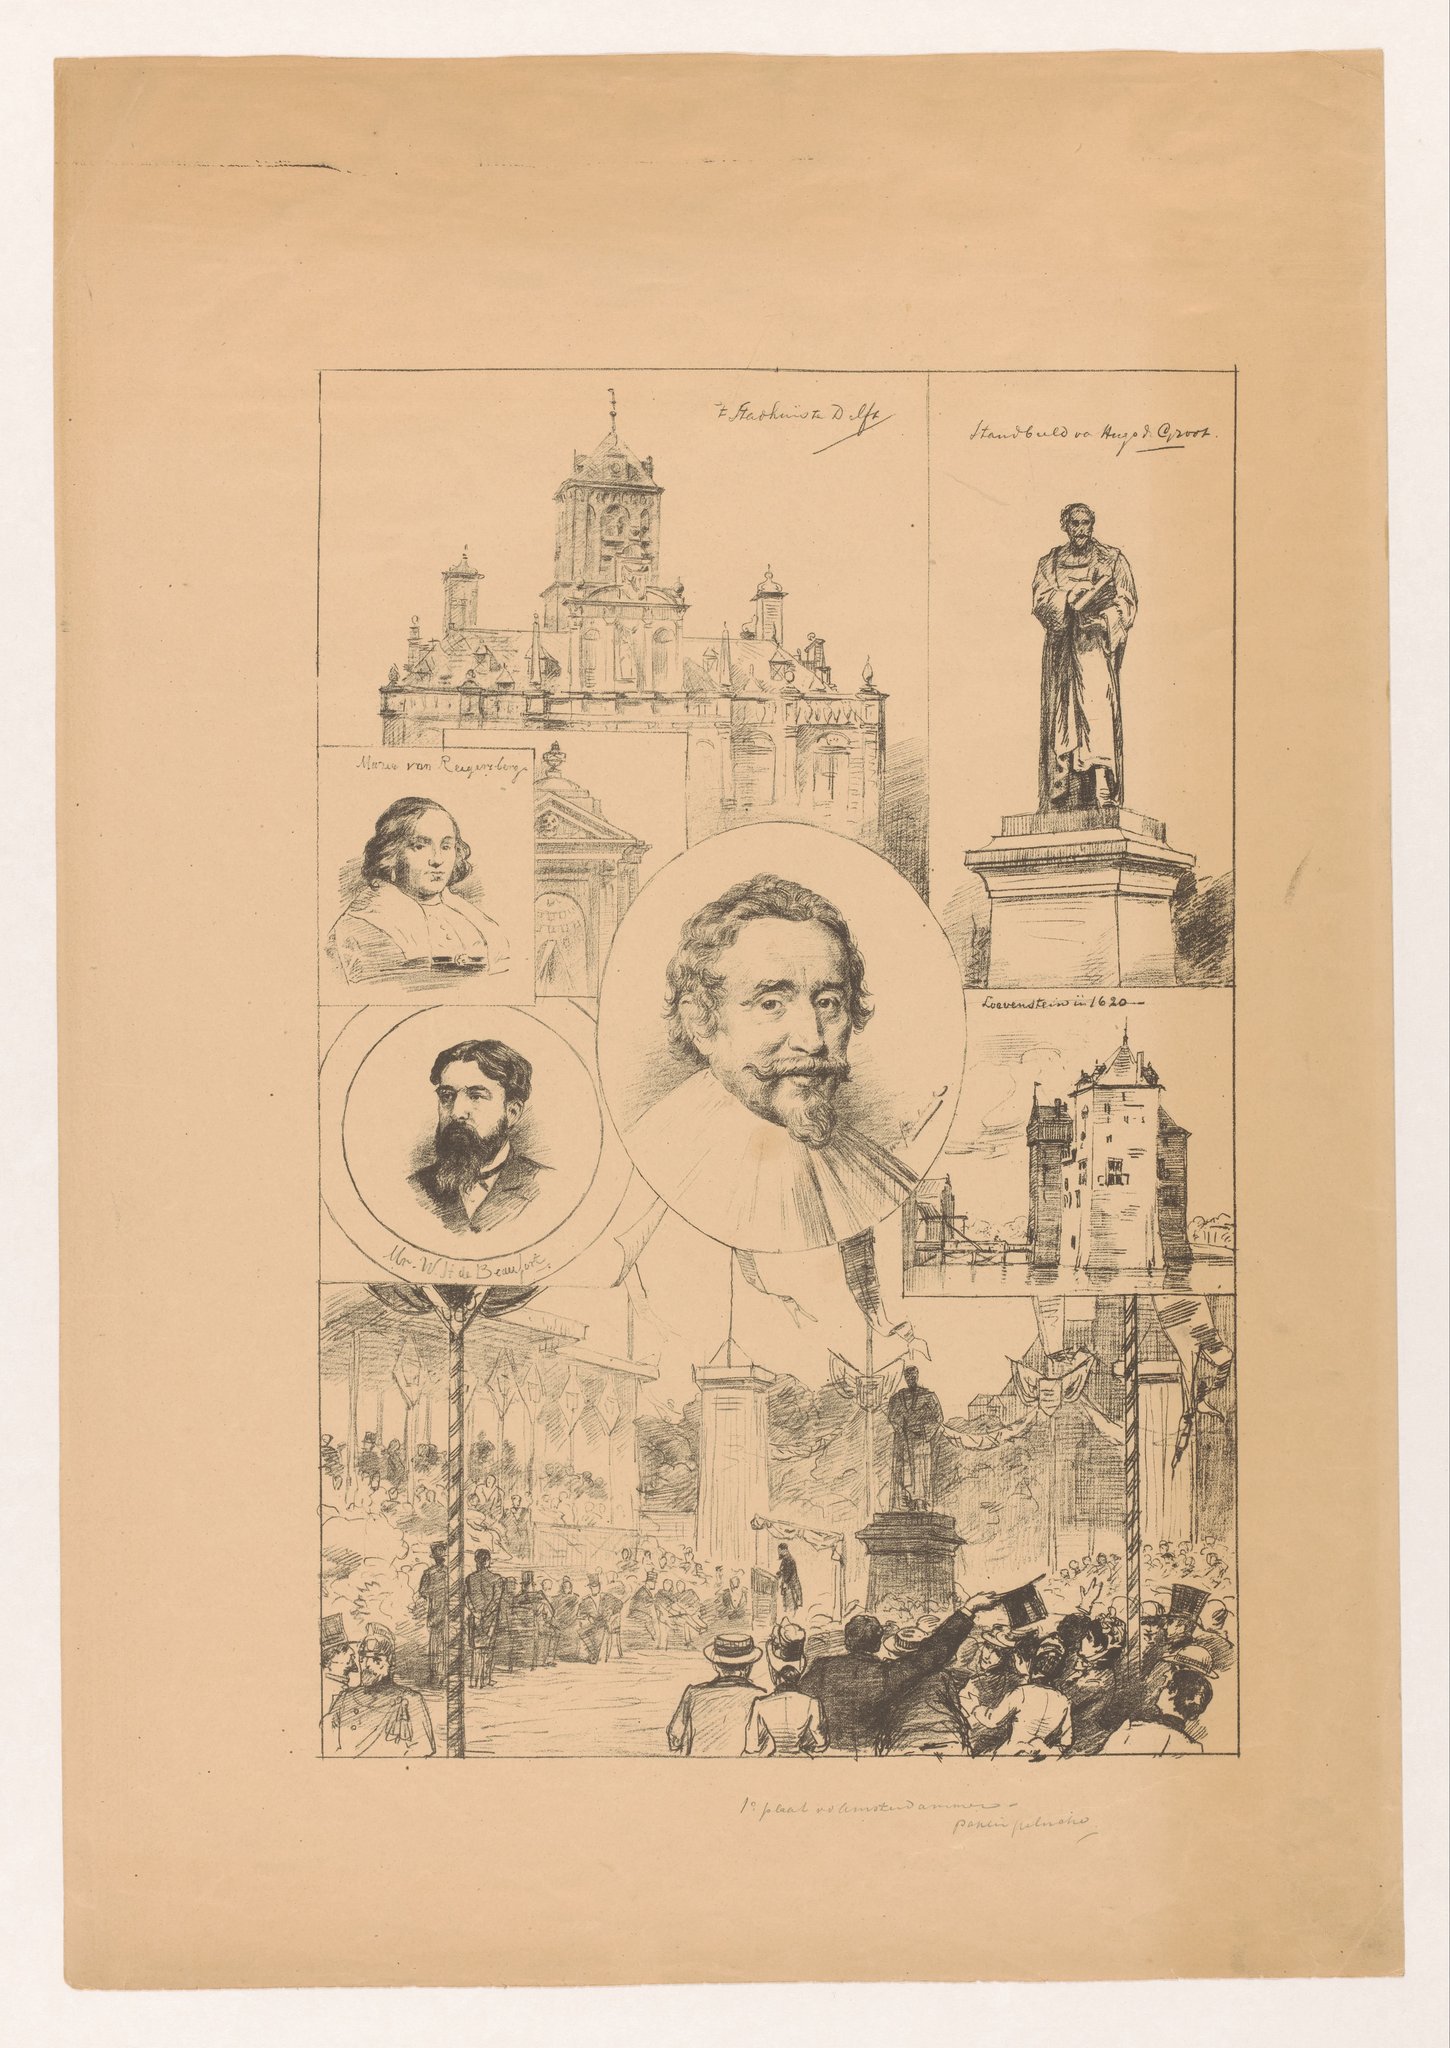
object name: print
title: 't Stadhuis te Delft / Standbeeld van Hugo de Groot / Maria van Reigersberg / Mr. W.H. de Beauforte / Loevenstein in 1620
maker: willem steelink (ii)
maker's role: draughtsman, print maker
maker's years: 1856-1928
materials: paper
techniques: lithograph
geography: netherlands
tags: delft, hugo de groot, the hague, historical persons, monument, statue, loevestein castle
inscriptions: collector's mark: Lugt 2228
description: Het portret van Hugo de Groot met rondom voor hem belangrijke plaatsen en figuren. Links boven: Het stadhuis van Delft. Rechts boven: Het standbeeld van Hugo de Groot te Delft. Links midden de portretten van zijn vrouw Maria van Reigersberch, die het plan voor de ontsnapping met de boekenkist had bedacht, en schrijver Willem Hendrik de Beaufort. Rechts midden Slot Loevestein in 1620. Midden onder de feestelijkheden rondom de onthulling van het standbeeld van Hugo de Groot te Delft in 1886.